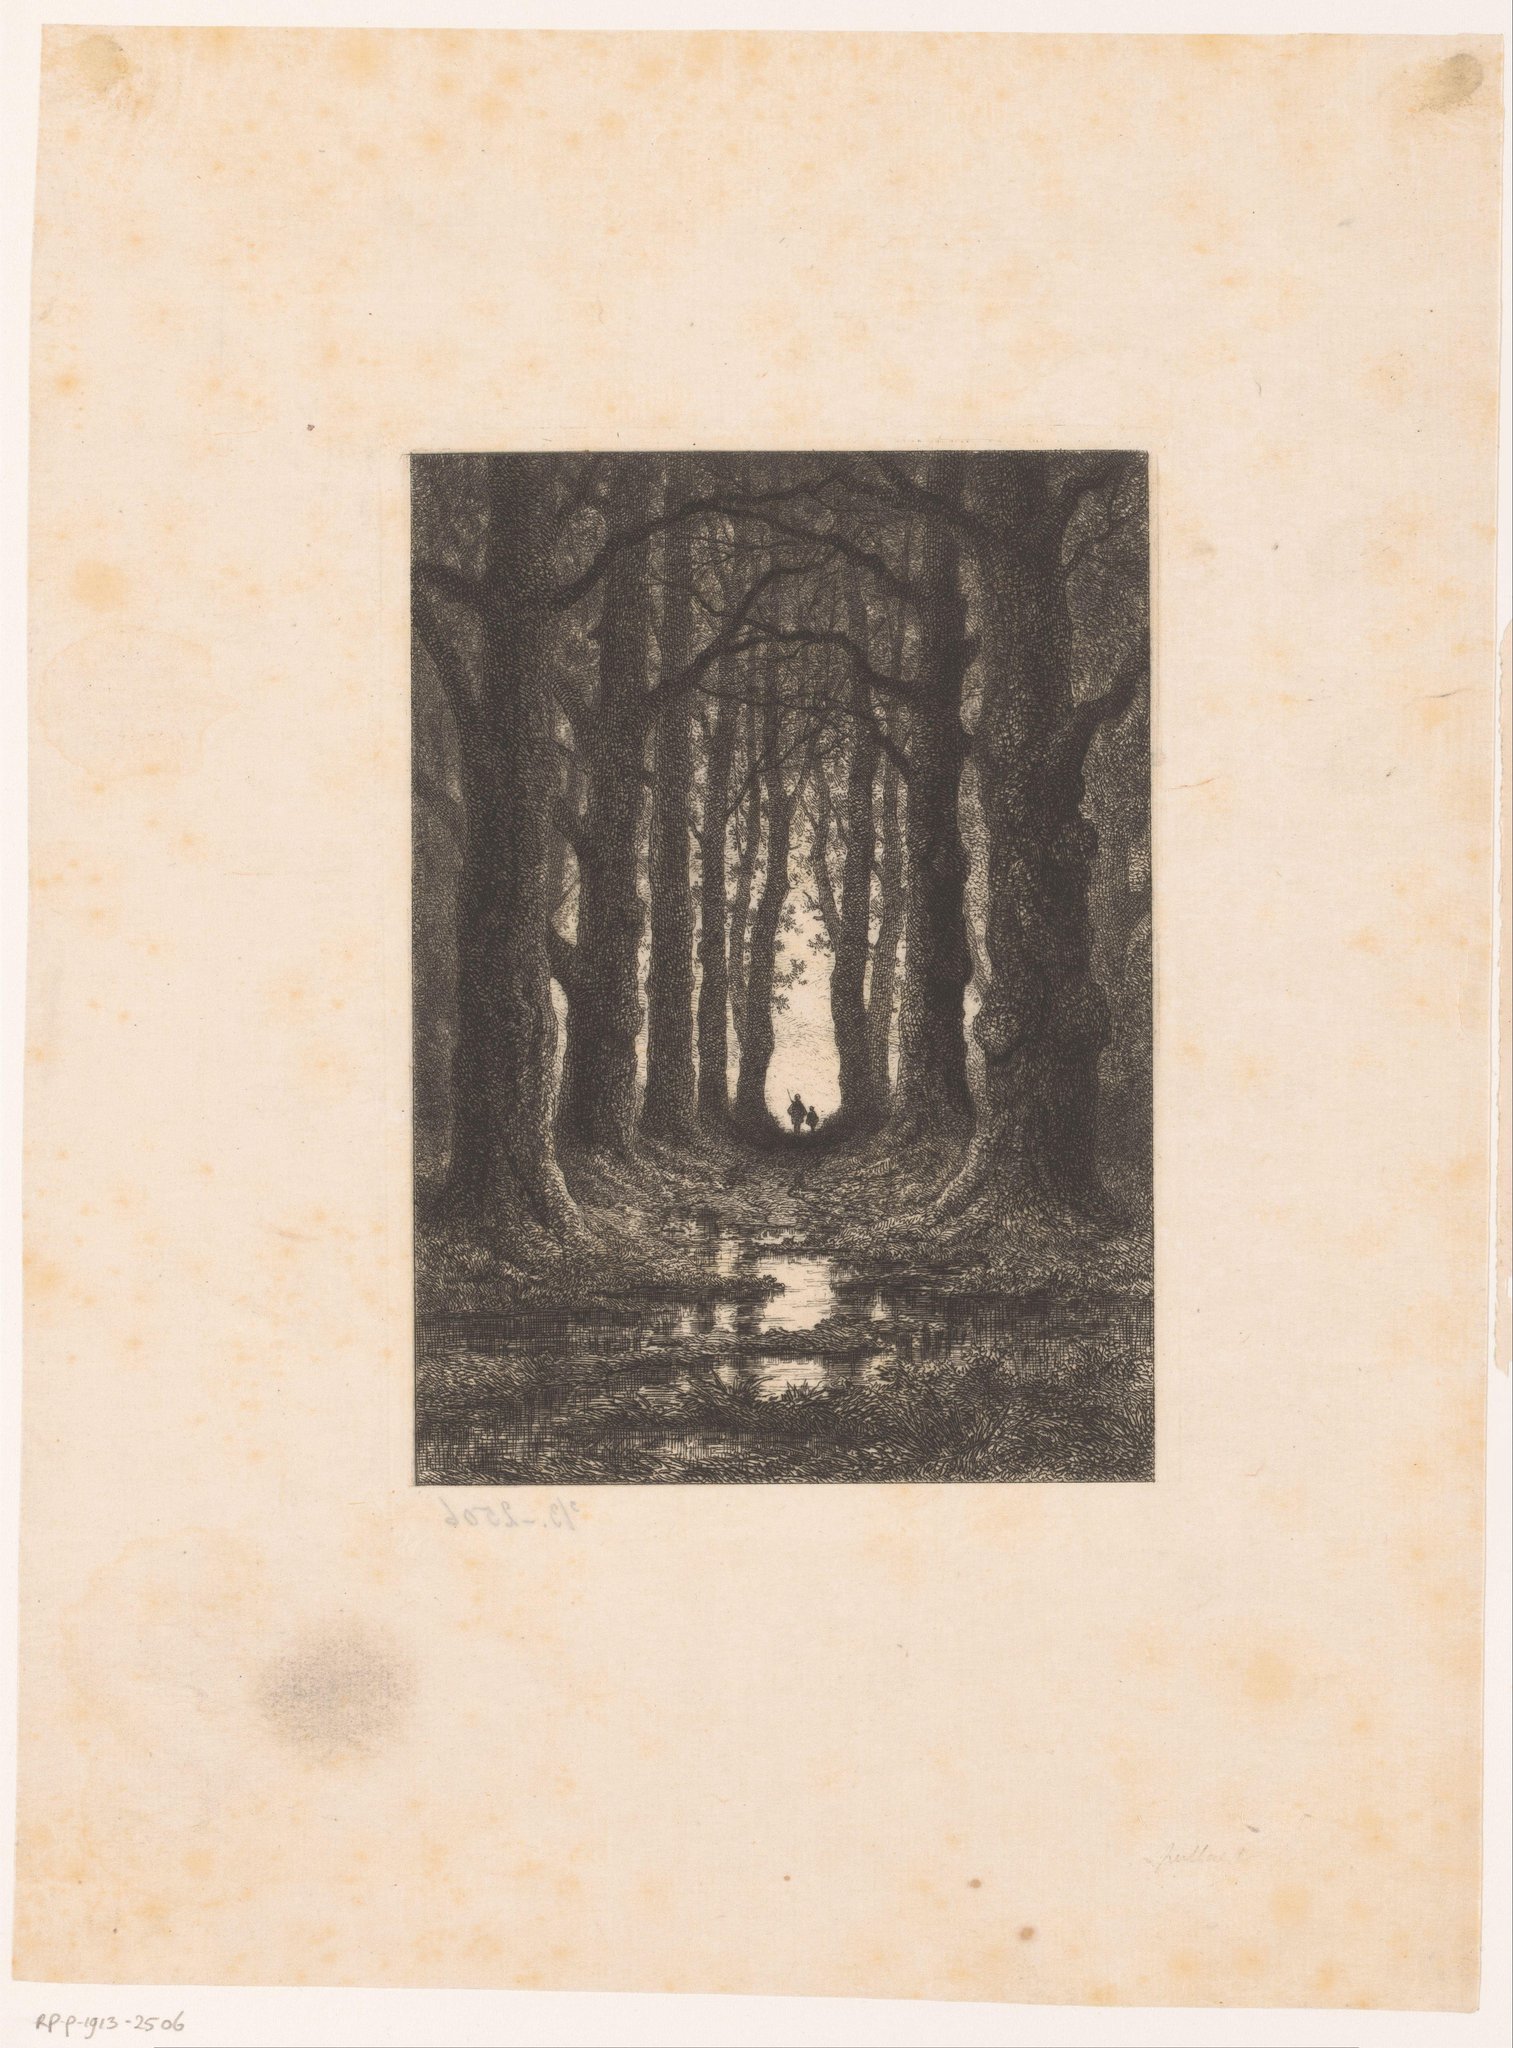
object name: print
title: Twee figuren lopen met zonsondergang in het Zoniënwoud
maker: emile puttaert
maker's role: print maker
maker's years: 1829-1901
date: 1839-1875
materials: paper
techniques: drypoint, etching, intaglio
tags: landscapes with waters, waterscapes, seascapes (in the temperate zone), forest, wood (+ landscape with figures, staffage)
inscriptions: collector's mark: Lugt 2228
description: Latere staat met ondertitel verschenen in: Album d'eaux-fortes originales et inédites. Brussel: Félix Callewaert, 1875.